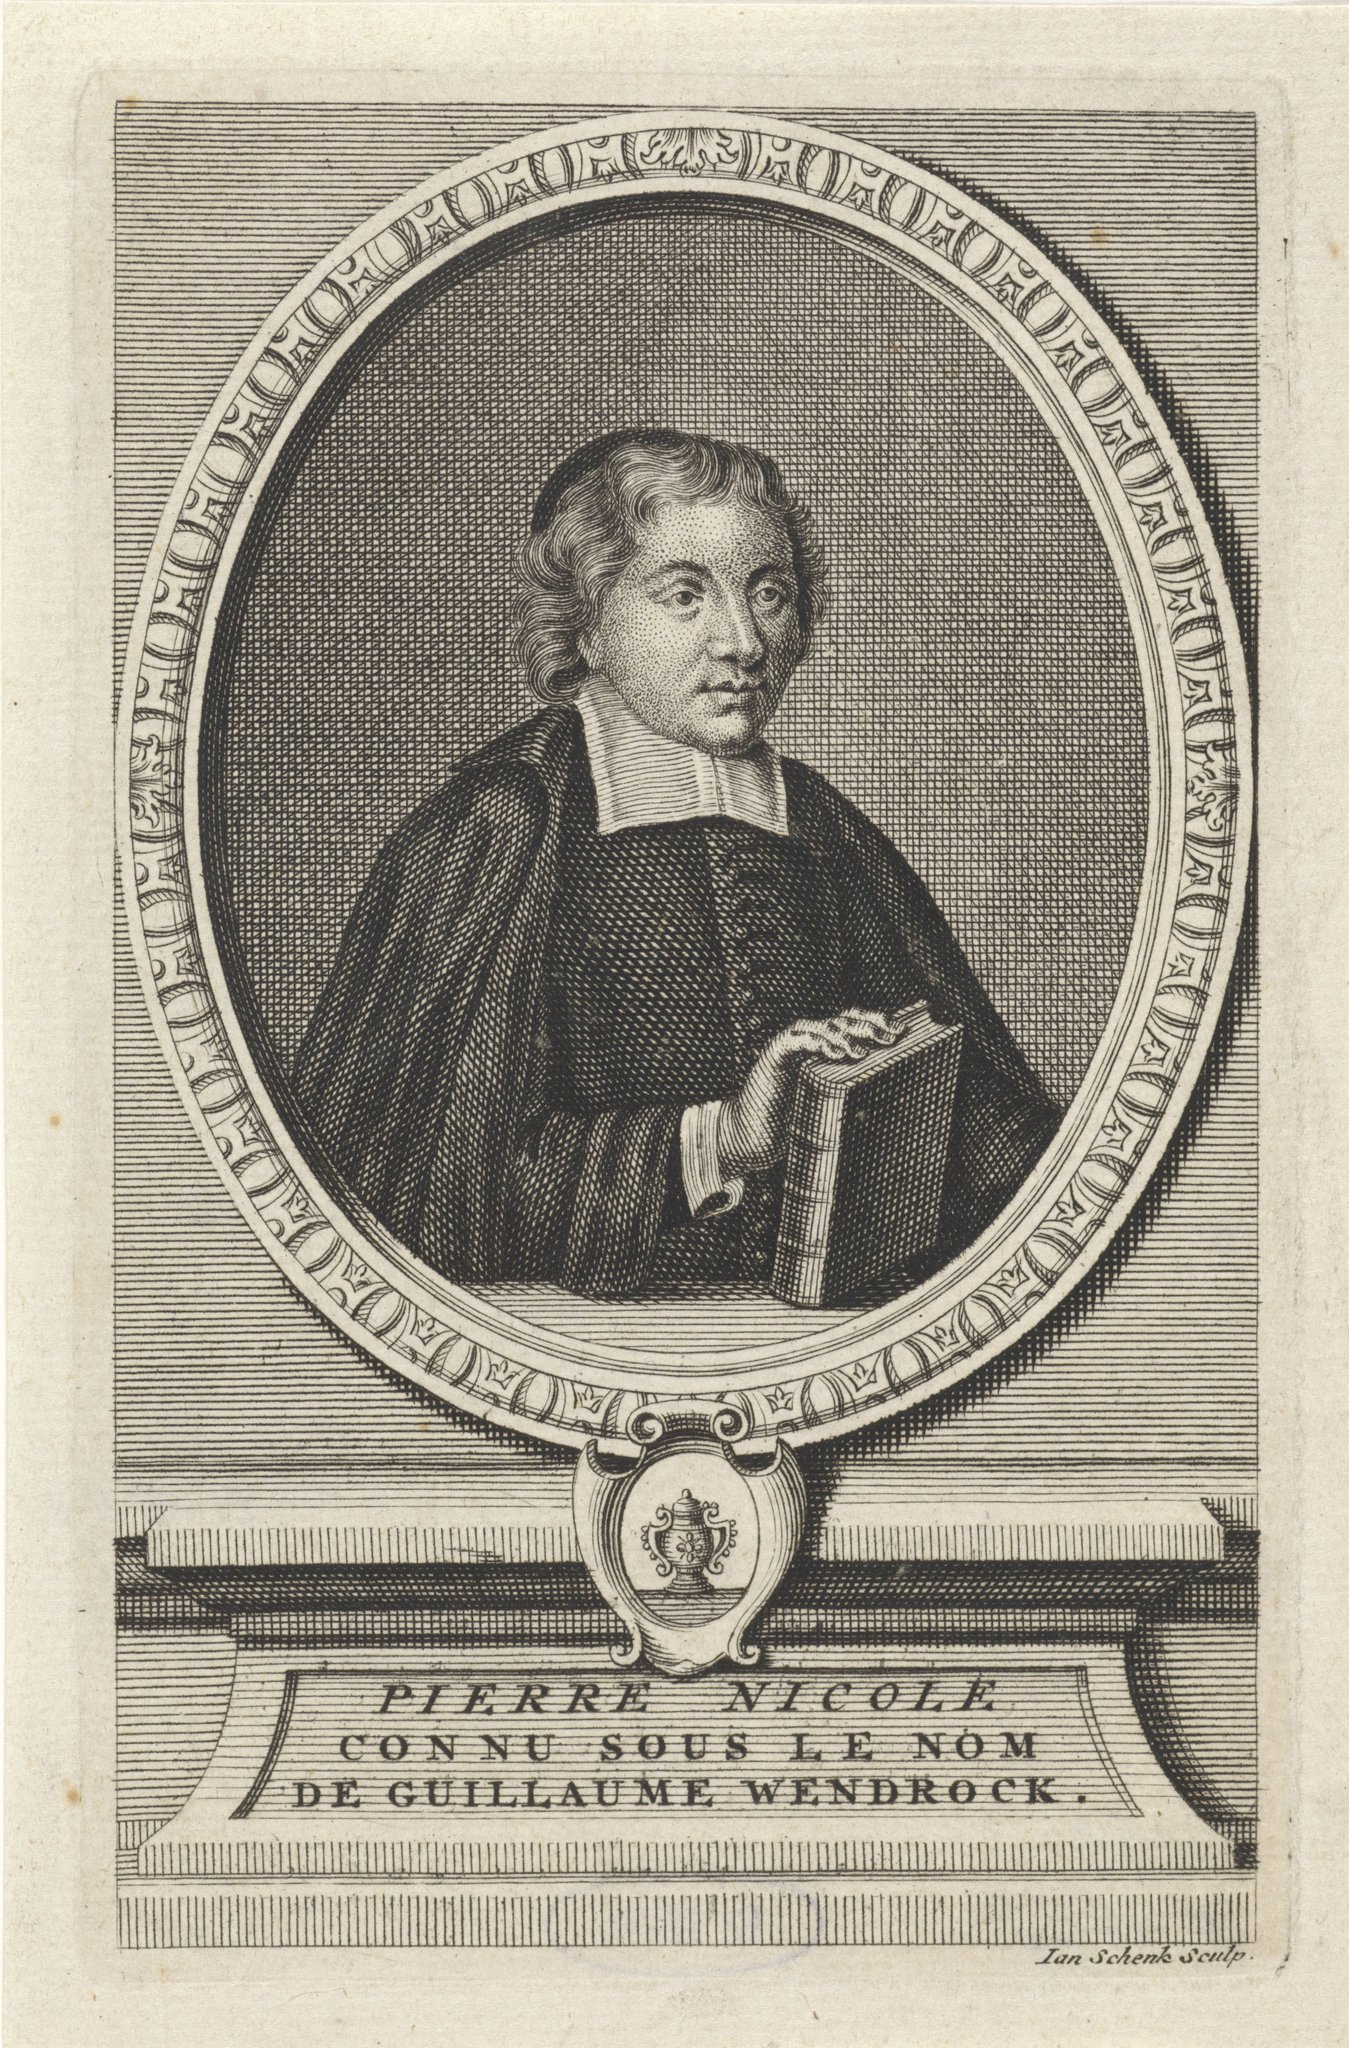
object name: print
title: Portret van Pierre Nicole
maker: jan schenk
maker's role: draughtsman, print maker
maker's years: 1698-1752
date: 1713-1752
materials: paper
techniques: engraving, etching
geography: amsterdam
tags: paris, historical persons, book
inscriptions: collector's mark: Lugt 2228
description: Portret naar rechts van de predikant Pierre Nicole in een ornamentele omlijsting. Zijn rechterhand rust op een boek. Onder het portret de naam van de geportretteerde.